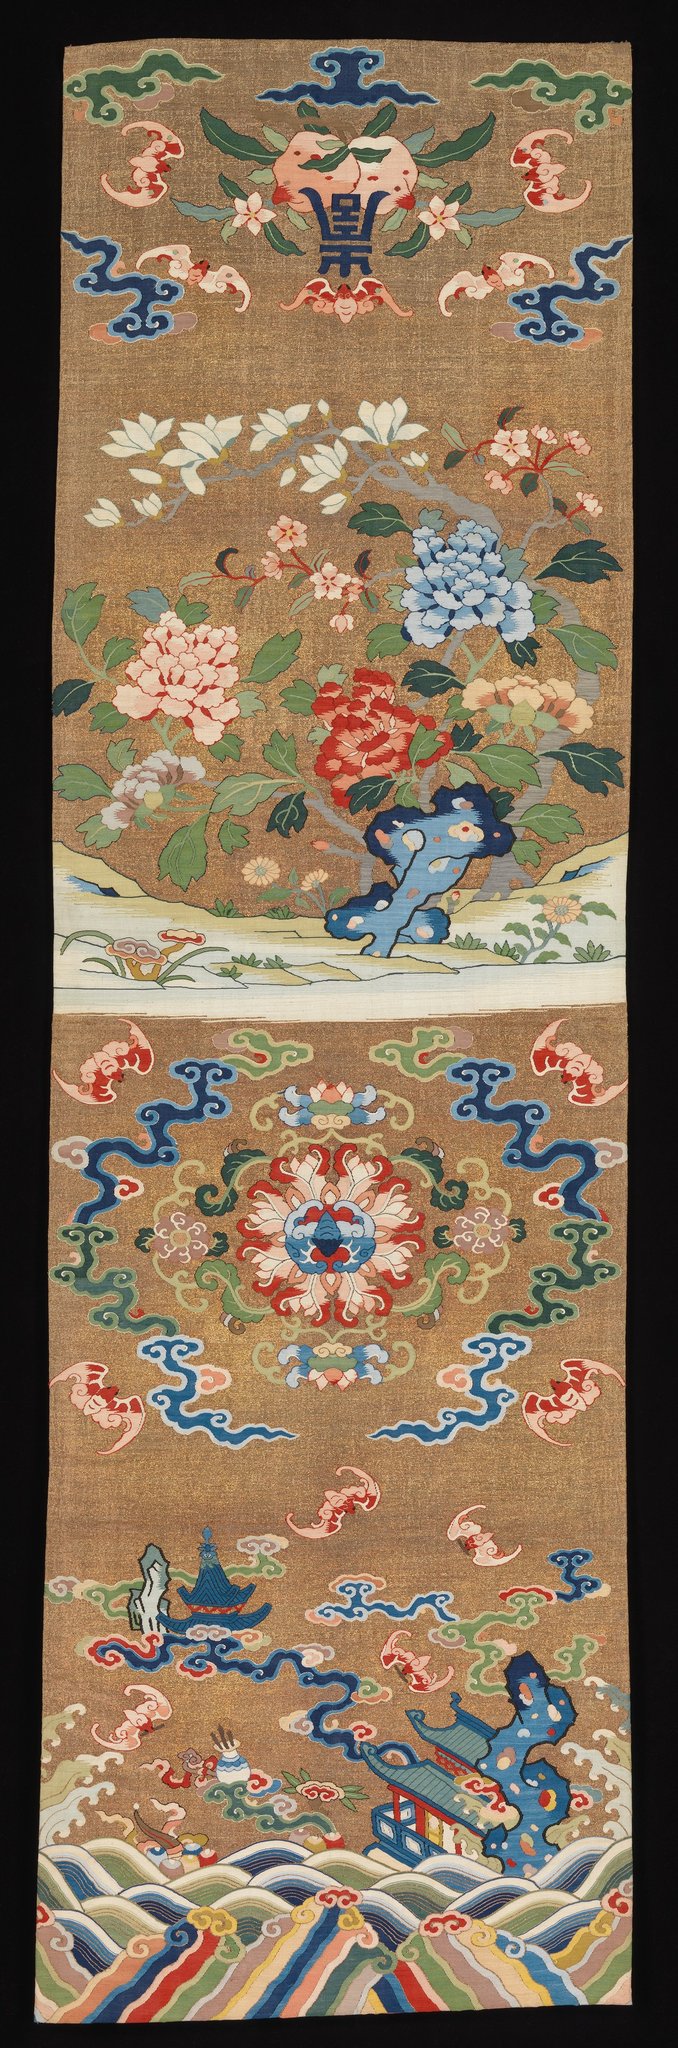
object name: chair strip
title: One of a Pair of Chair Strips with Auspicious Patterns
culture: chinese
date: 1701-1800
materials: metal thread, silk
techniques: tapestry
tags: flowers